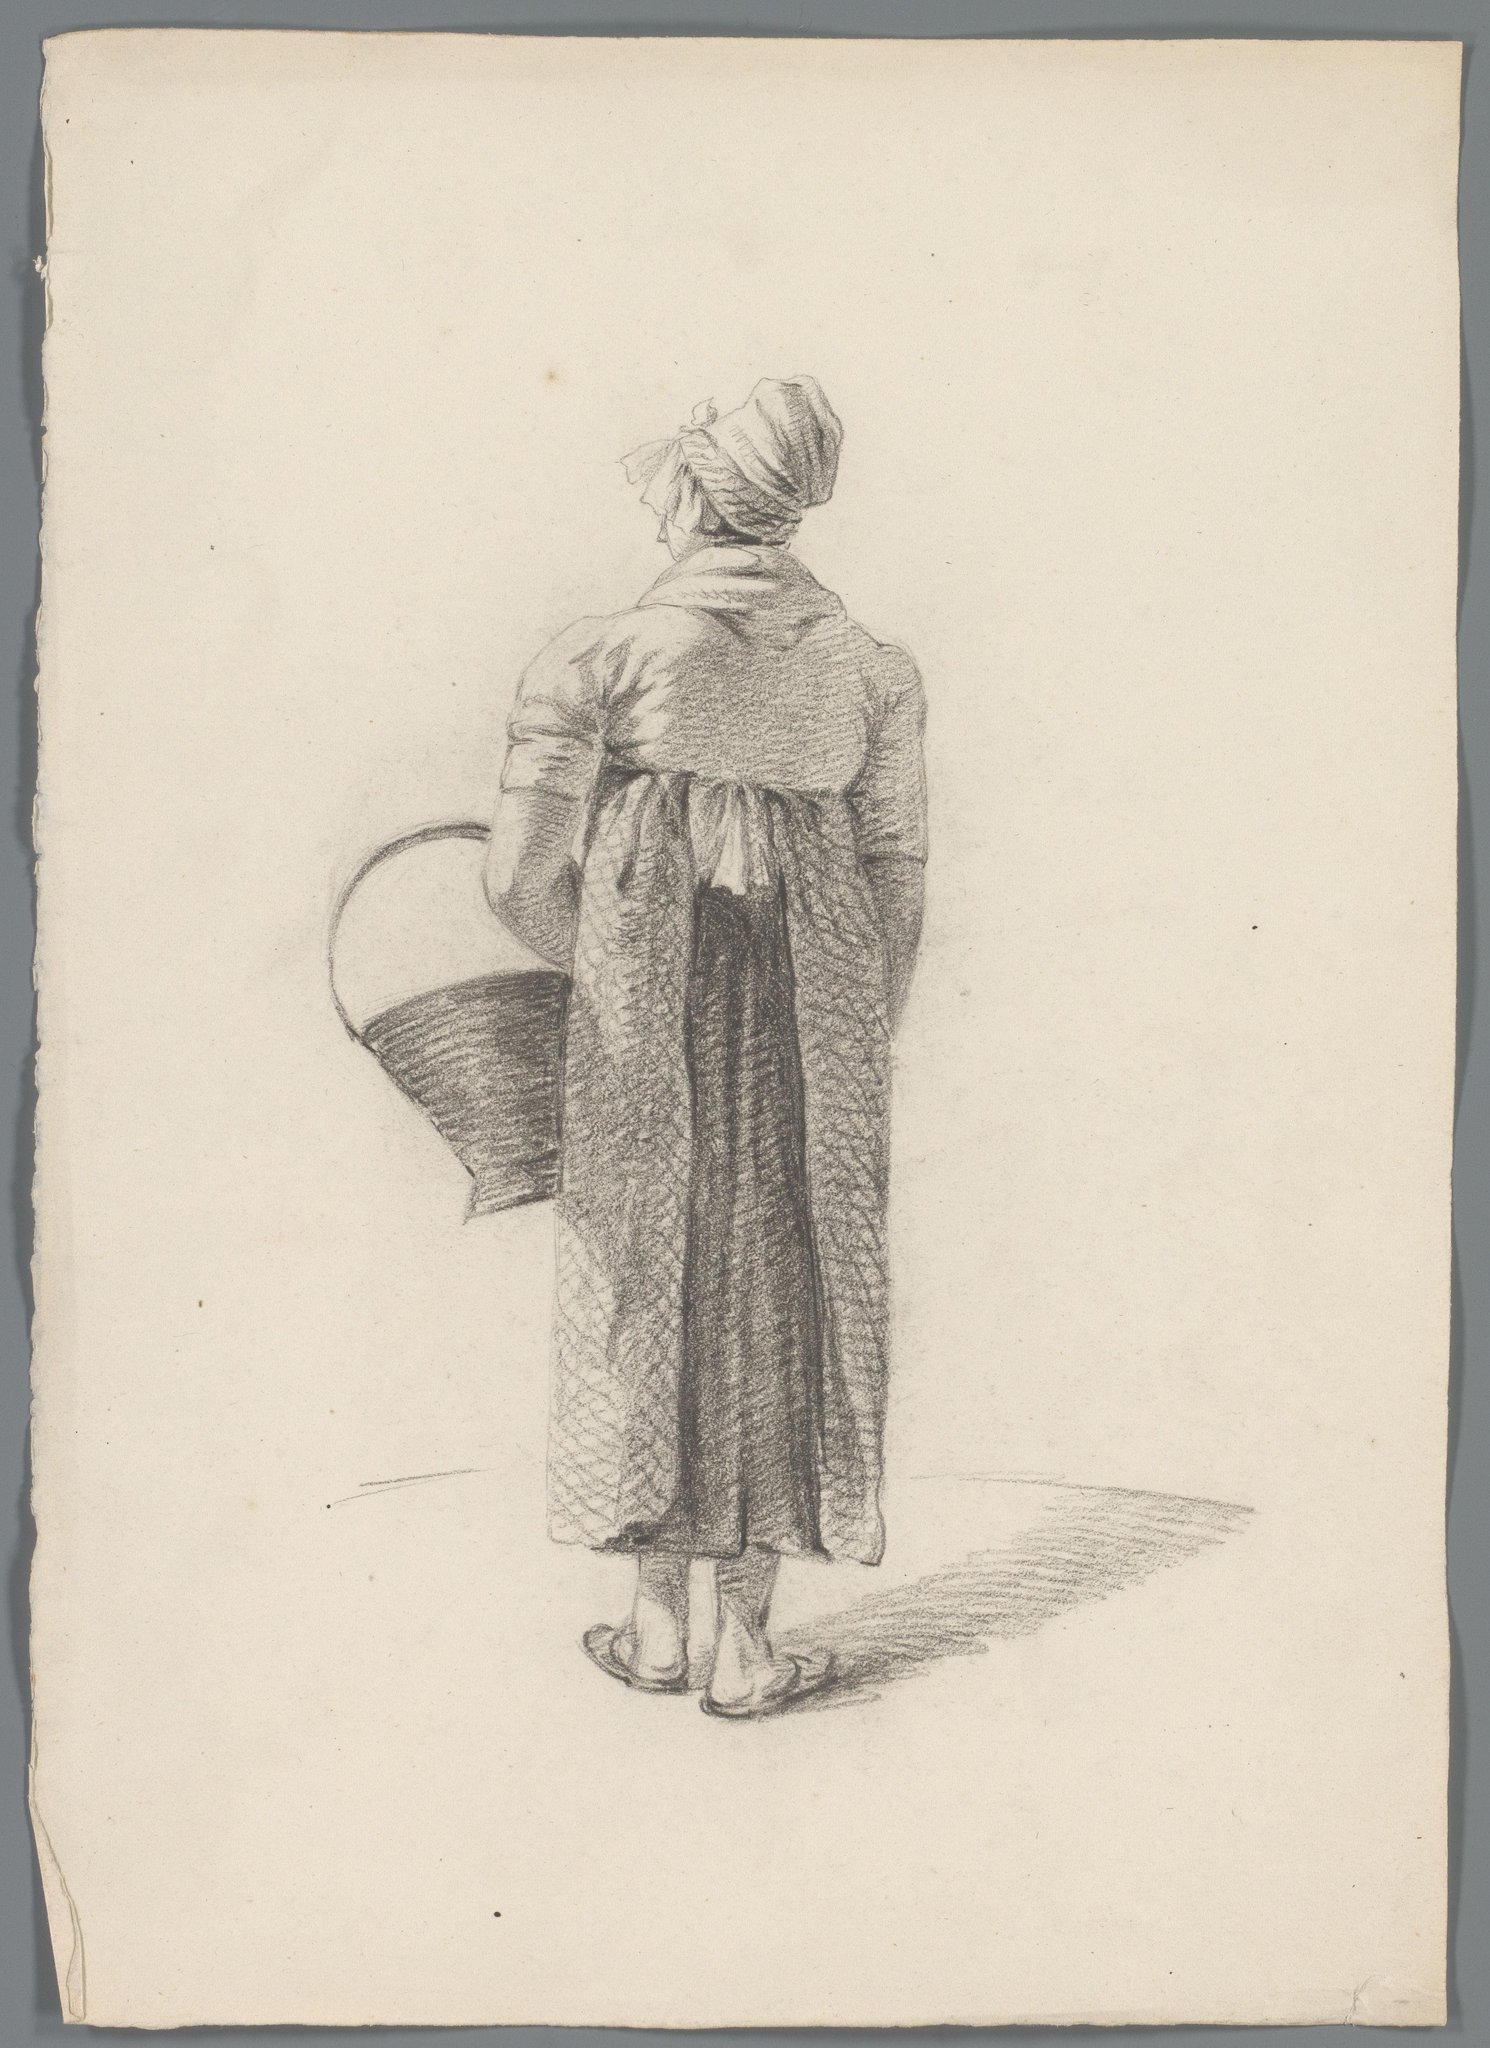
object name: drawing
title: Vrouw met mand, op de rug gezien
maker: Anonymous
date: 1820-1830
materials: chalk, paper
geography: the hague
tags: adult woman, container made of plant material other than wood: basket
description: Tekeningen waarschijnlijk ontstaan bij het Haagse kunstgenootschap ‘Tot Nut der Tekenkunst’, waar twee keer per week tekenavonden werden georganiseerd met geklede modellen.